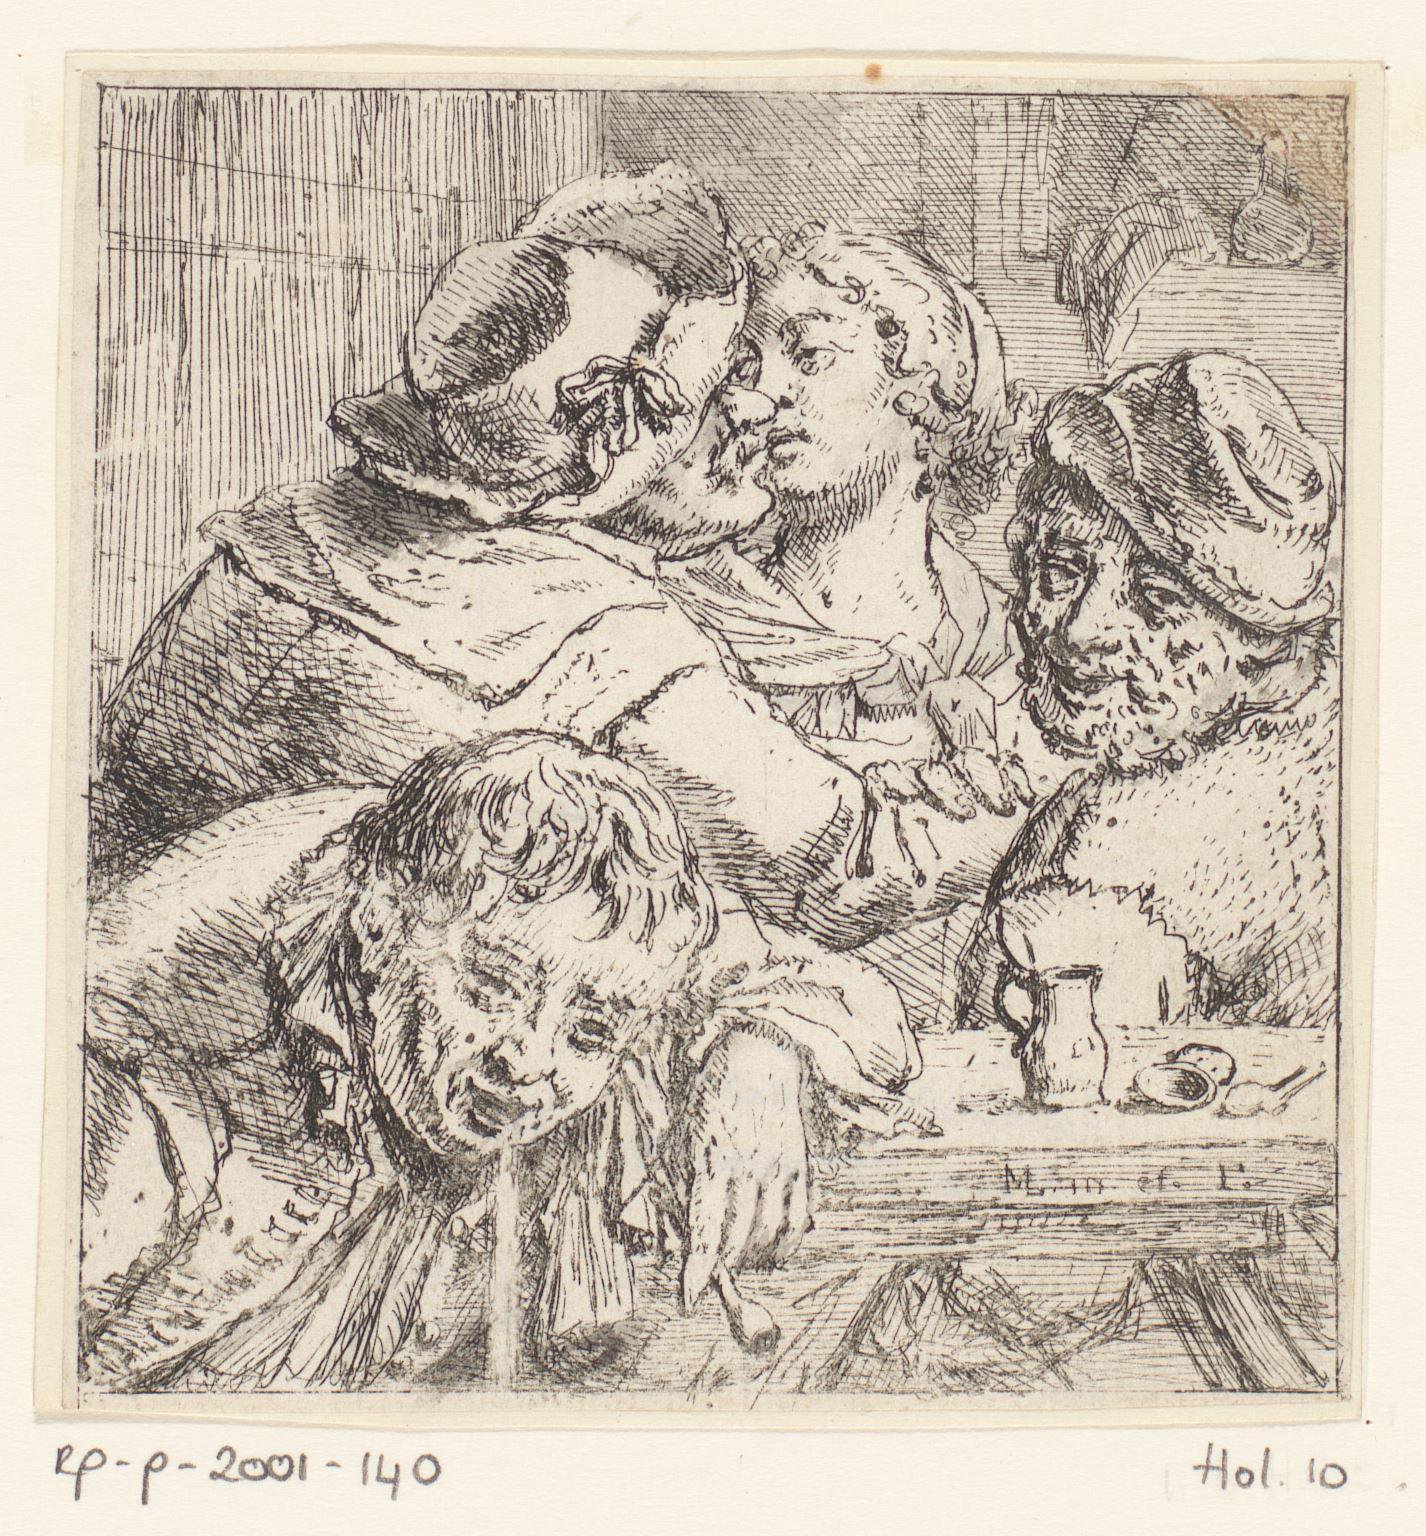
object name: print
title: Vier figuren in een herberginterieur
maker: marcellus laroon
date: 1663-1702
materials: paper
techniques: etching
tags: vomiting, embracing each other, kissing, inn, coffee-house, public house, etc., pipe ~ tobacco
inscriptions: collector's mark: Lugt 2760, collector's mark: Lugt 2228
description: Drie mannen en een vrouw in een herberginterieur. Er wordt gedronken, gezoend en, als gevolg van te veel drank, overgegeven.